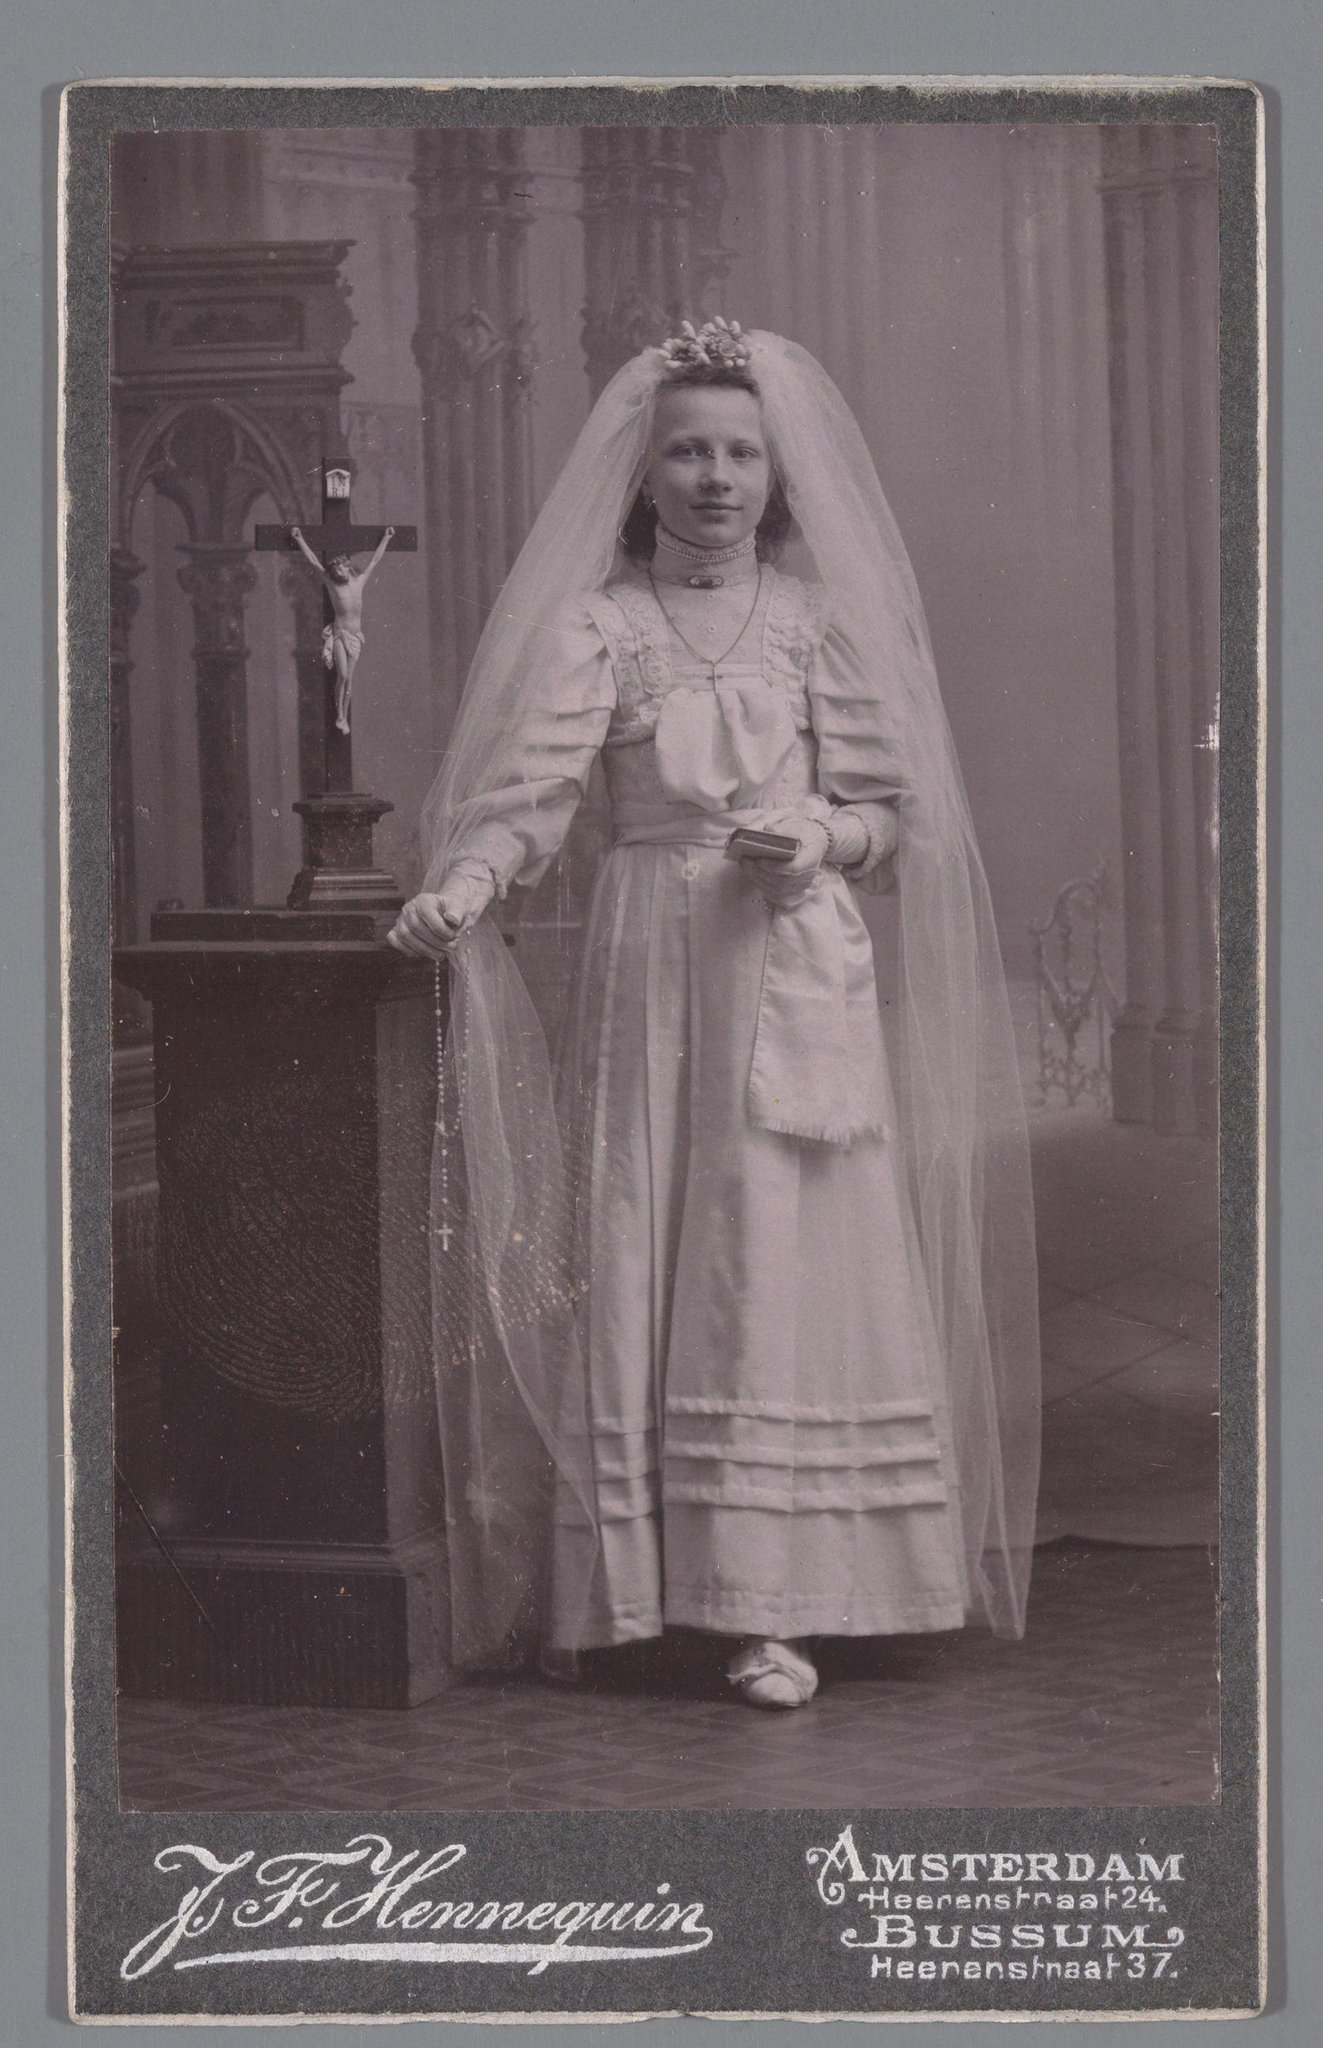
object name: photograph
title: Portret van een onbekend meisje in een communiejurk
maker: johannes franciscus hennequin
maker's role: fotograaf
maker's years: 1850-1925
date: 1888-1903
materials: cardboard, photographic support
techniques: daylight paper print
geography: bussum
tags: first communion, communion dress